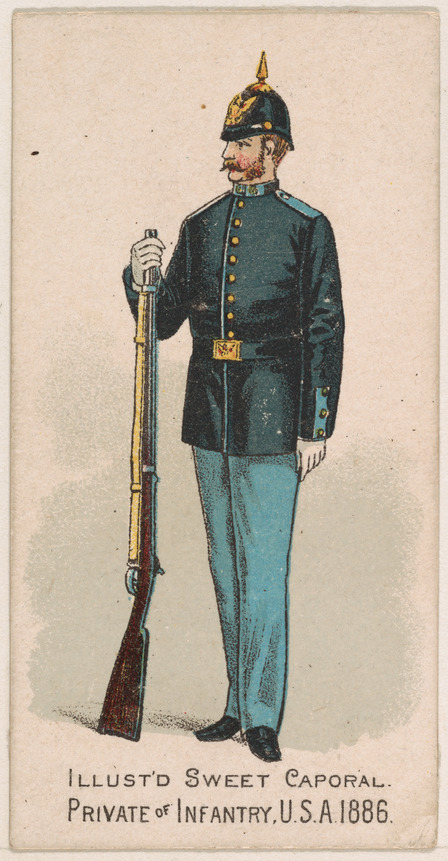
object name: print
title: Private, Infantry, United States Army, 1886, from the Military Series (N224) issued by Kinney Tobacco Company to promote Sweet Caporal Cigarettes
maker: kinney brothers tobacco company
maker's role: publisher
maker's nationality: american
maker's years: 1869-2011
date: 1888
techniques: color lithograph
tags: military,firearms,men,profiles